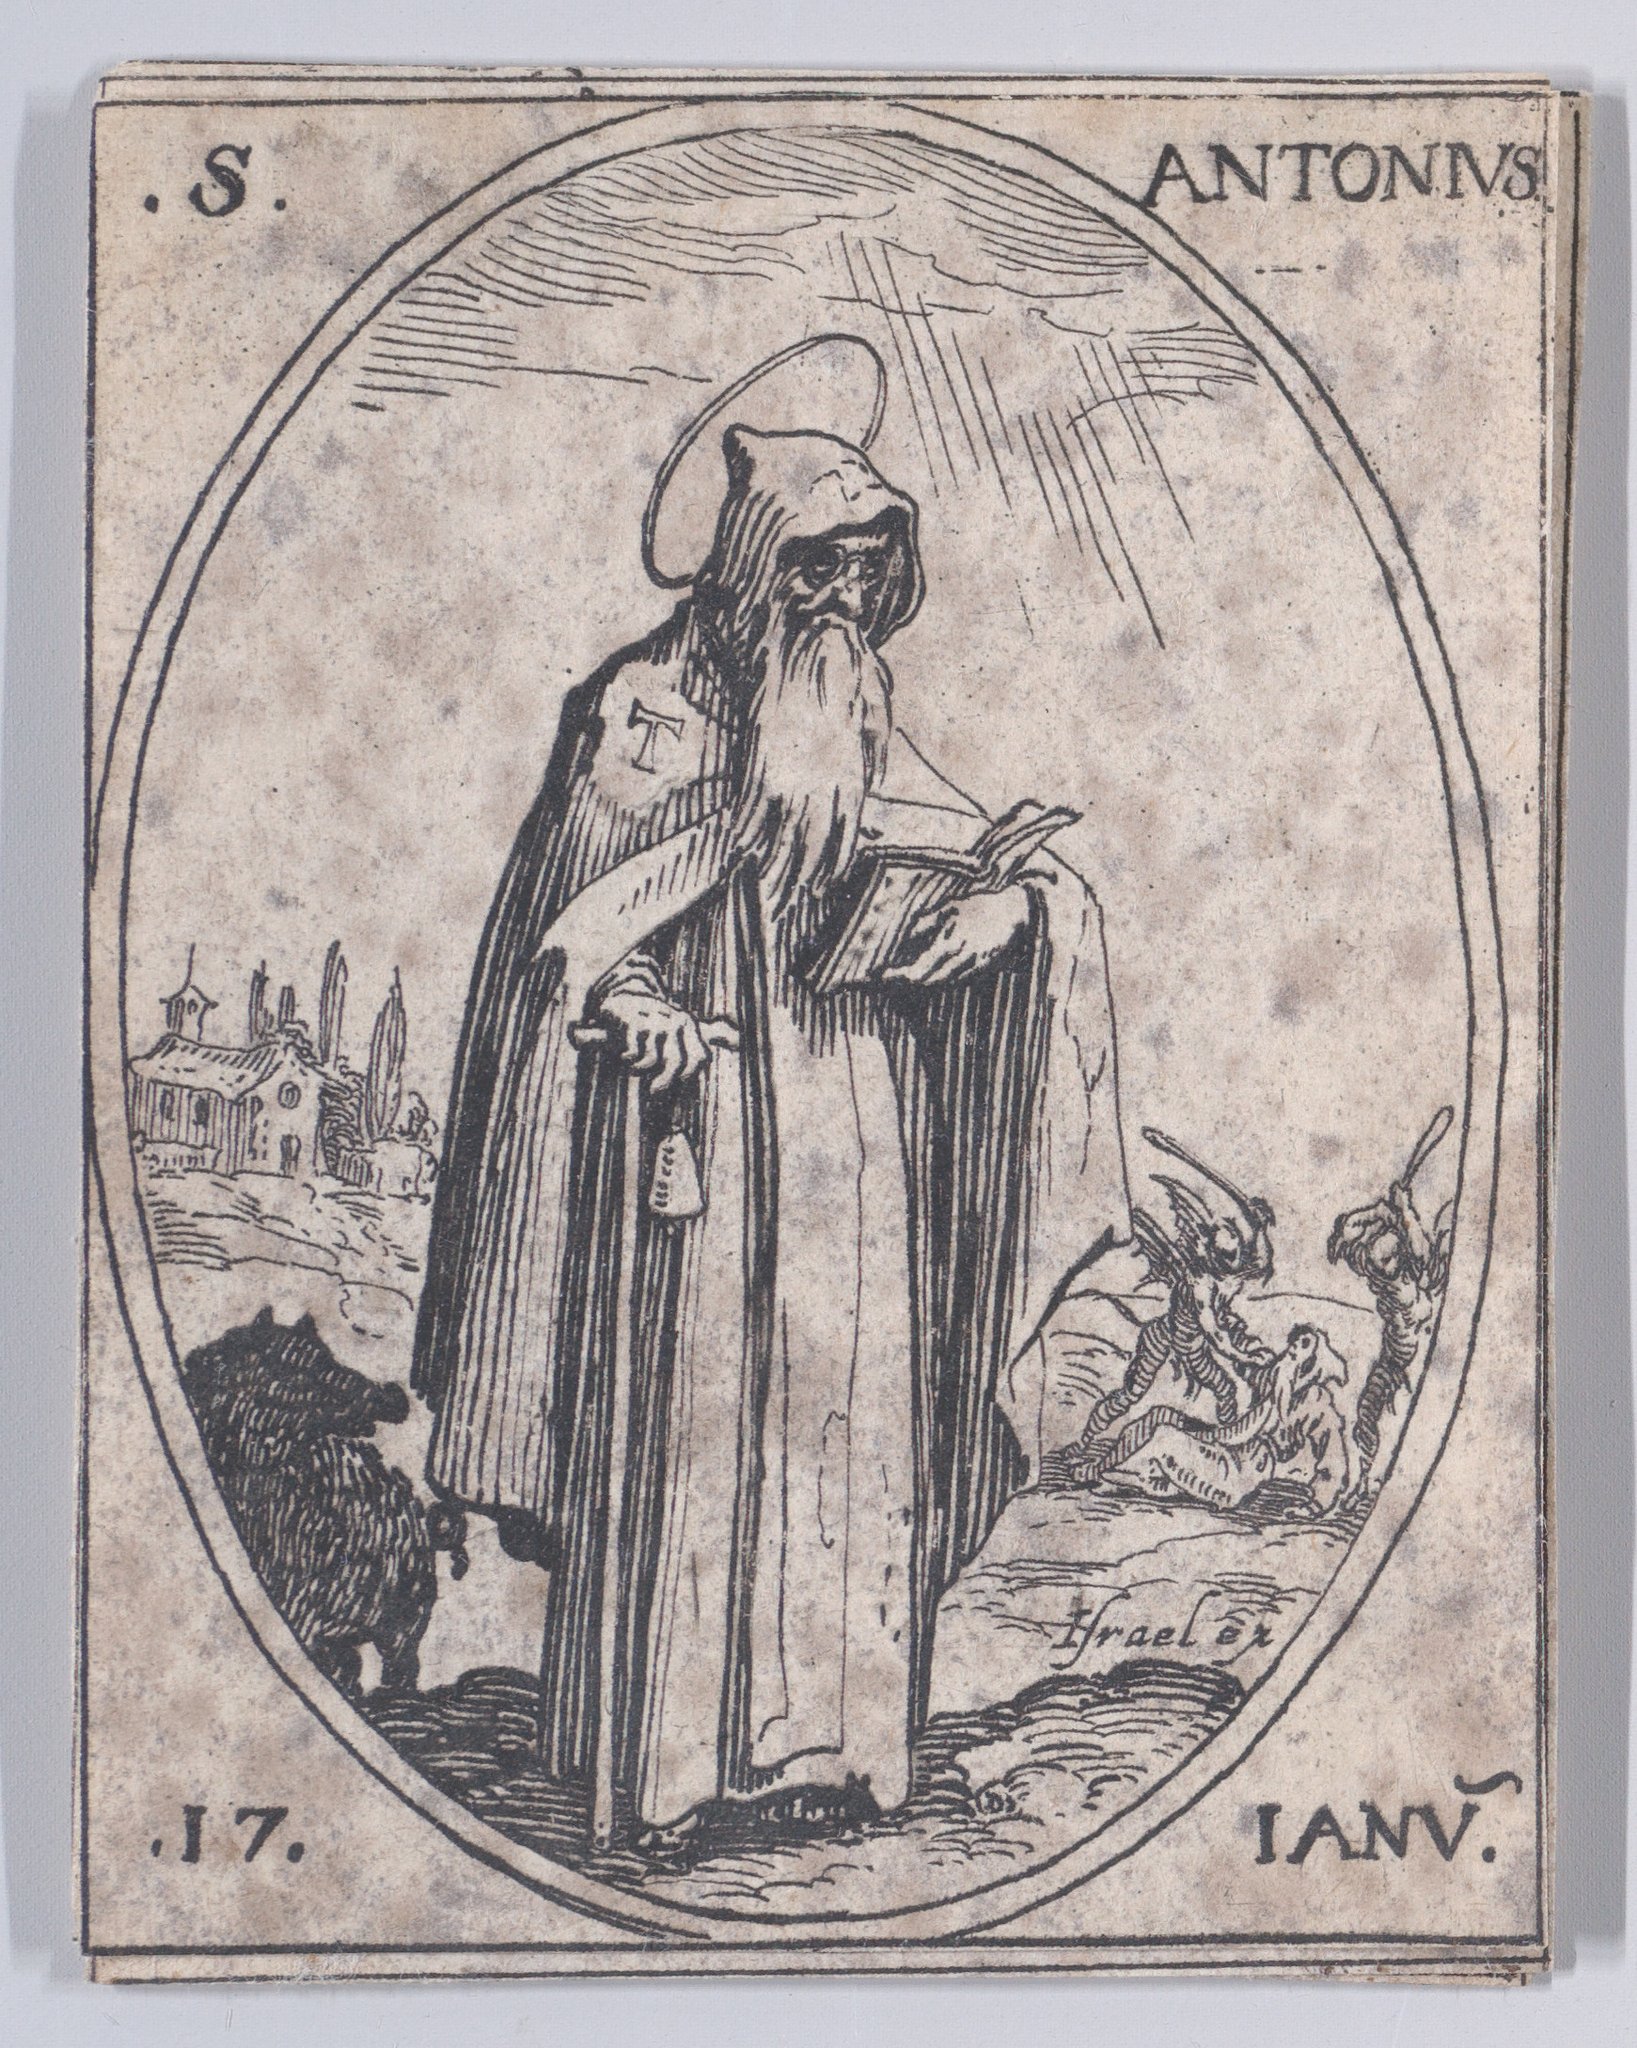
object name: print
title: S. Antoine (St. Anthony), January 17th, from "Les Images De Tous Les Saincts et Saintes de L'Année" (Images of All of the Saints and Feast Days of the Year)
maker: jacques callot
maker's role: artist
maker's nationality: french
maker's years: 1592-1635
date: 1636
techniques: etching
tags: men,saints